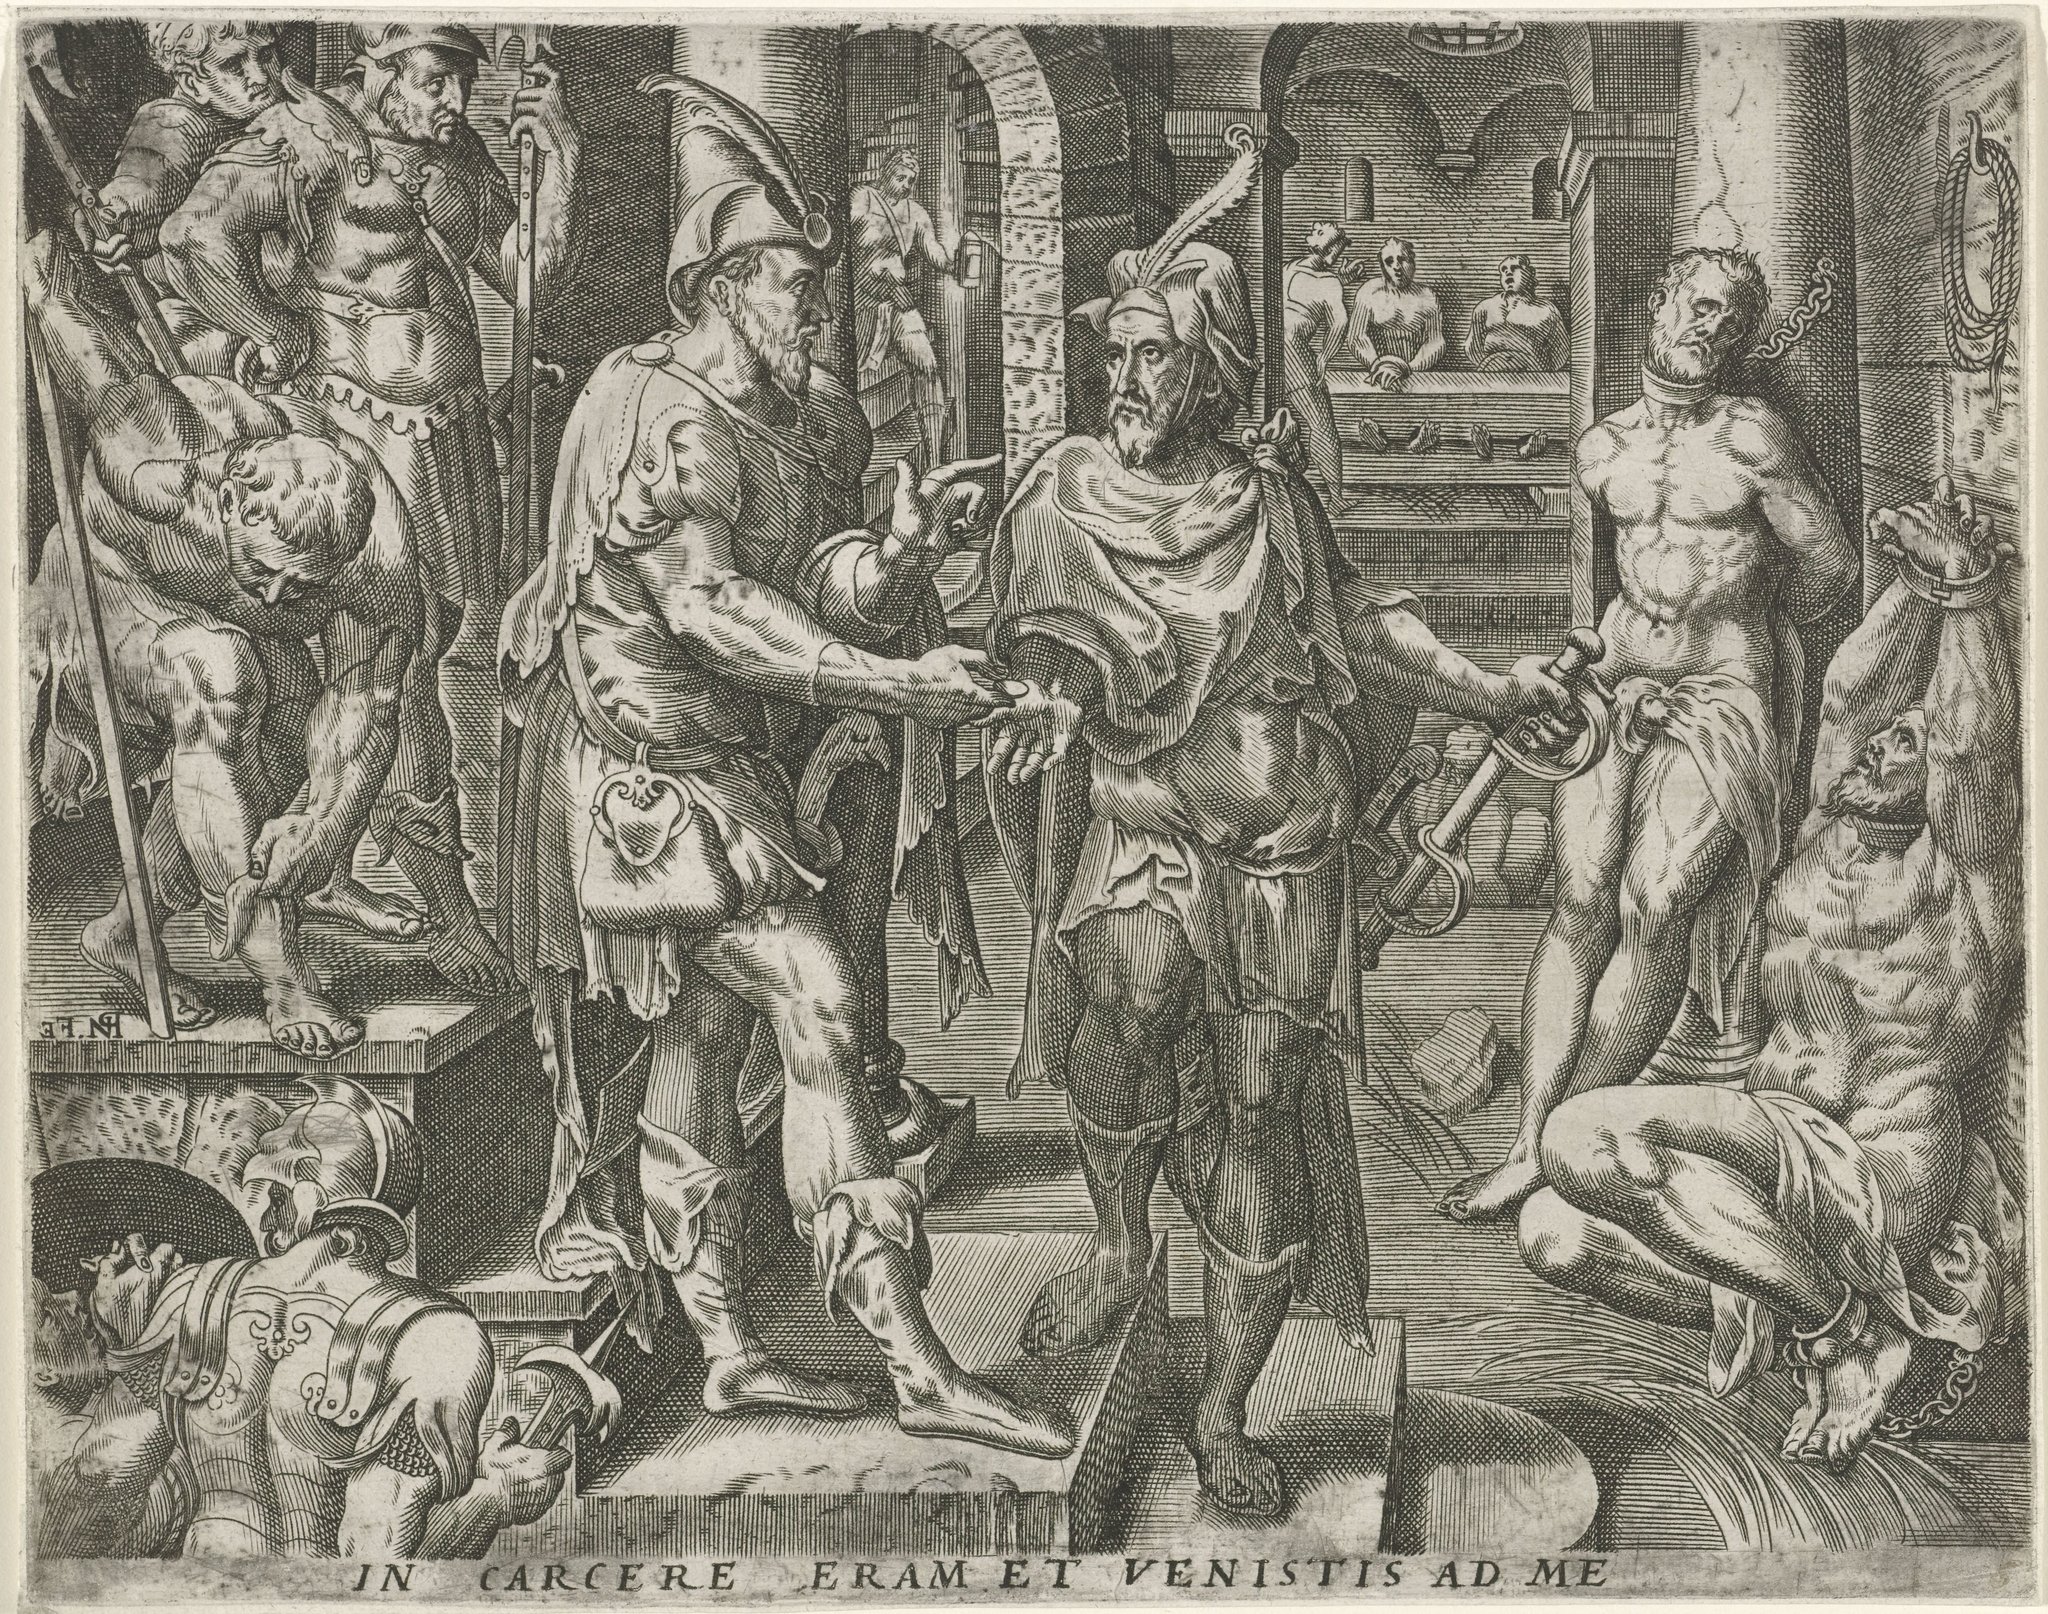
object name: print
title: Werken van barmhartigheid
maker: pieter nagel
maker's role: print maker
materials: paper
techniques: engraving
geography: antwerp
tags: visiting or liberating the imprisoned, 'incarceratus solatur' ~ one of the (seven) acts of mercy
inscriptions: collector's mark: Lugt 2228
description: Twee mannen bezoeken de gevangenen. Links op de trap een voorover gebogen bezoeker en een soldaat. Rechts twee aan de muur geketende gevangenen en op de achtergrond andere gevangenen. Onderaan in de marge een regel tekst in het Latijn. Prent uit een serie over de werken van barmhartigheid.